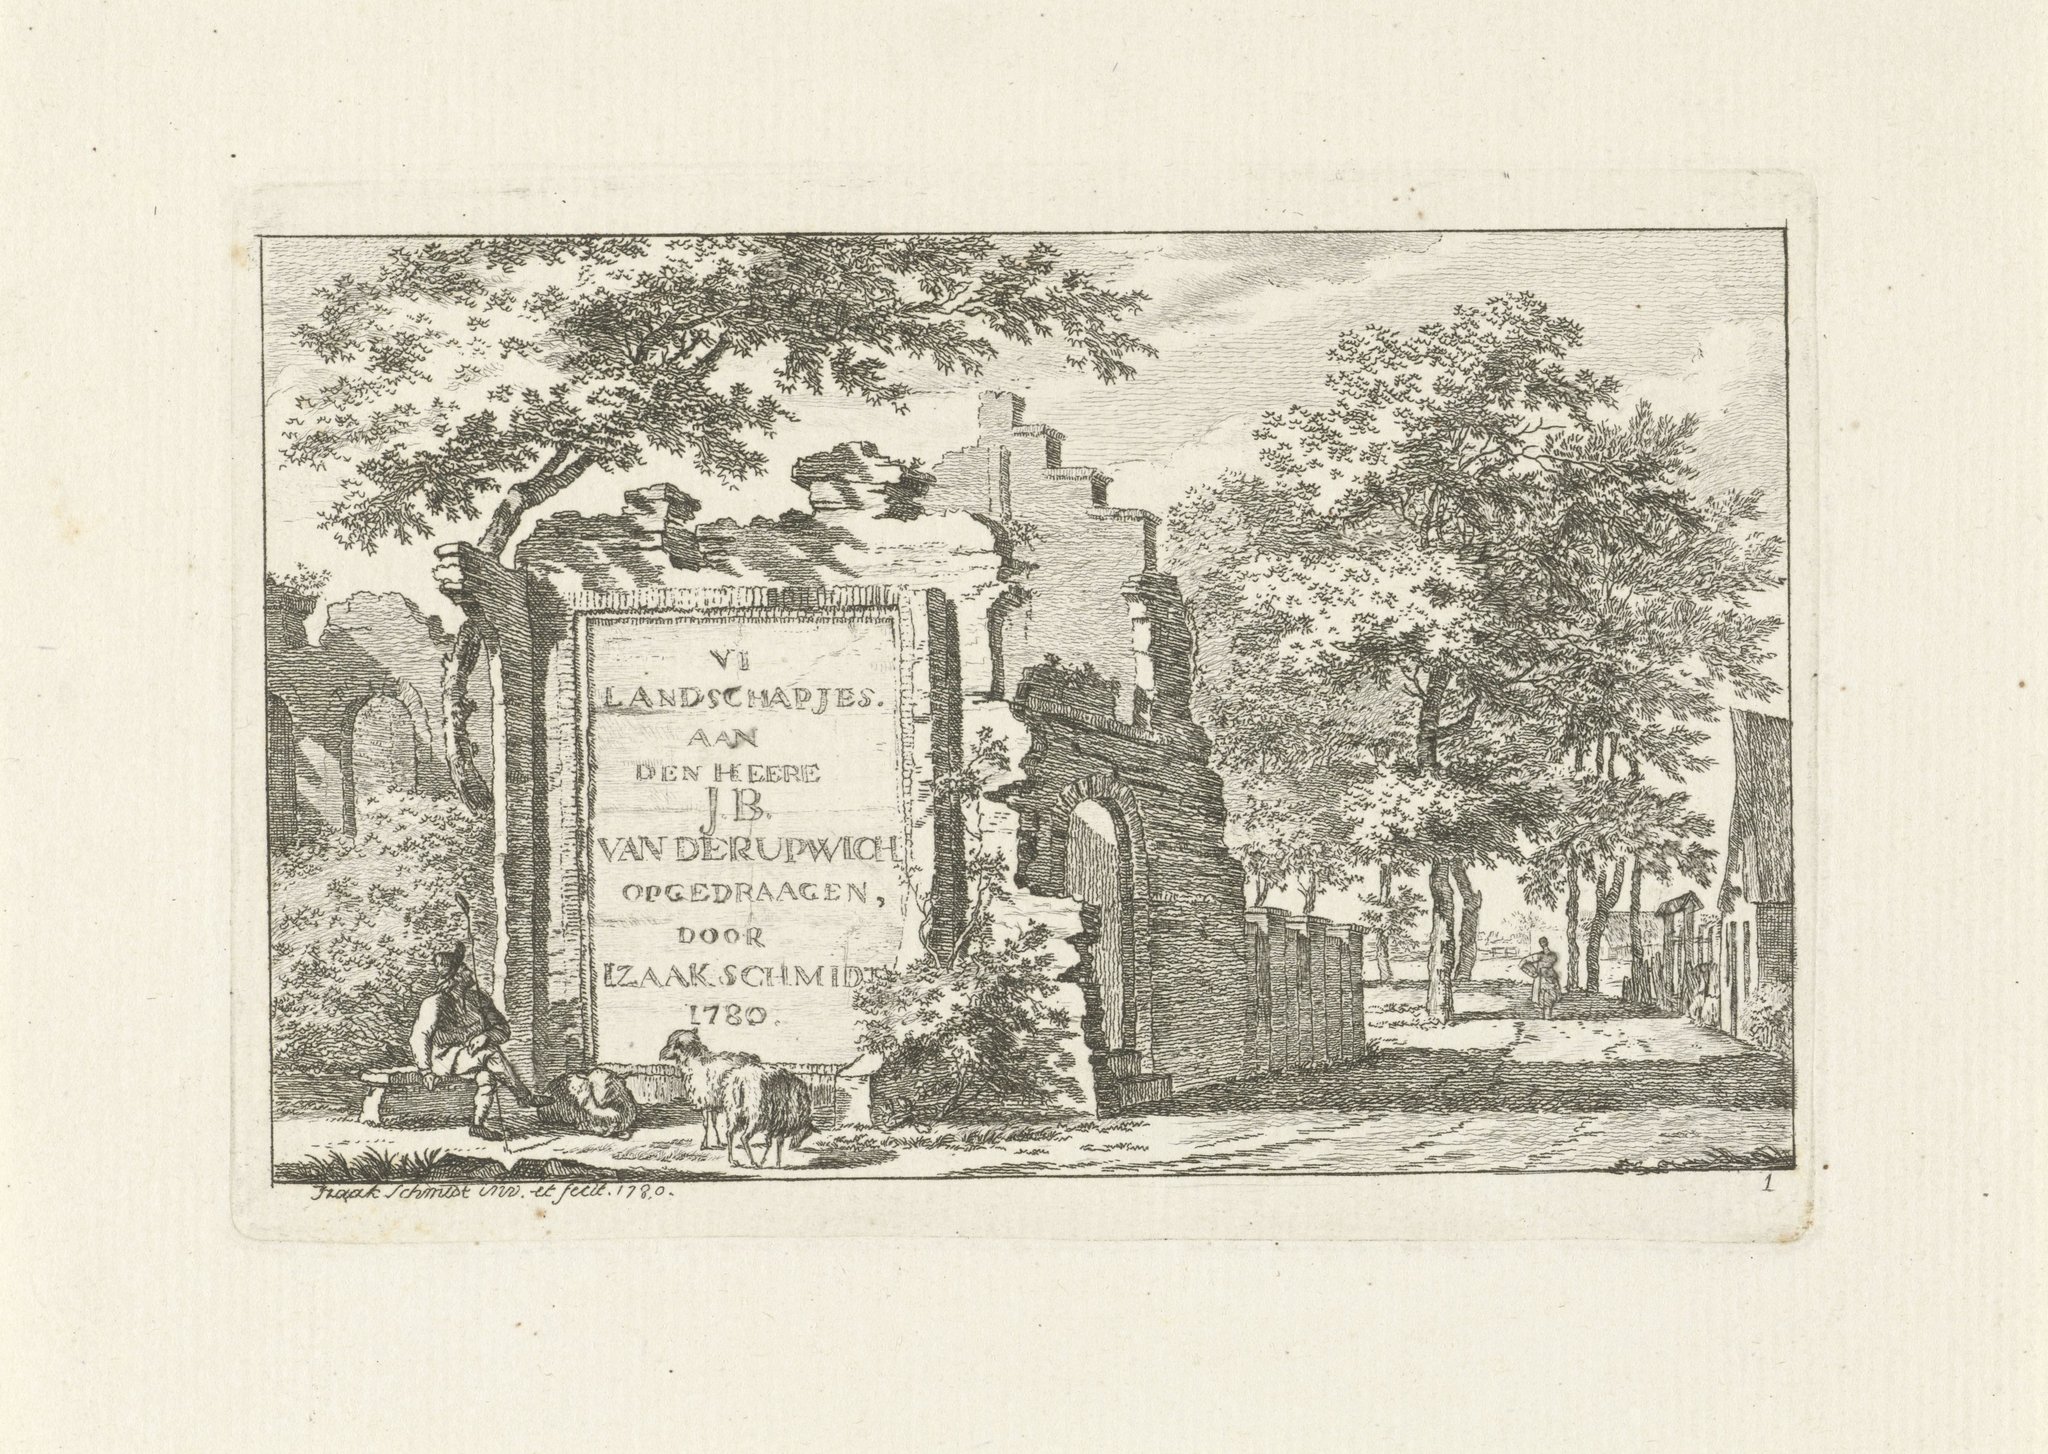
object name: print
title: Herder bij een ruïne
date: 1780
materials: paper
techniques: etching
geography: amsterdam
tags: herding, herdsman, herdswoman, shepherd, shepherdess, cowherd, etc., landscape with ruins, sheep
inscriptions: collector's mark: Lugt 240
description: Gezicht op een dorpsweg met op de voorgrond een herder met schapen bij een ruïne. Op de ruïne een plaquette met de titel. Titelprent van een serie van zes landschappen.